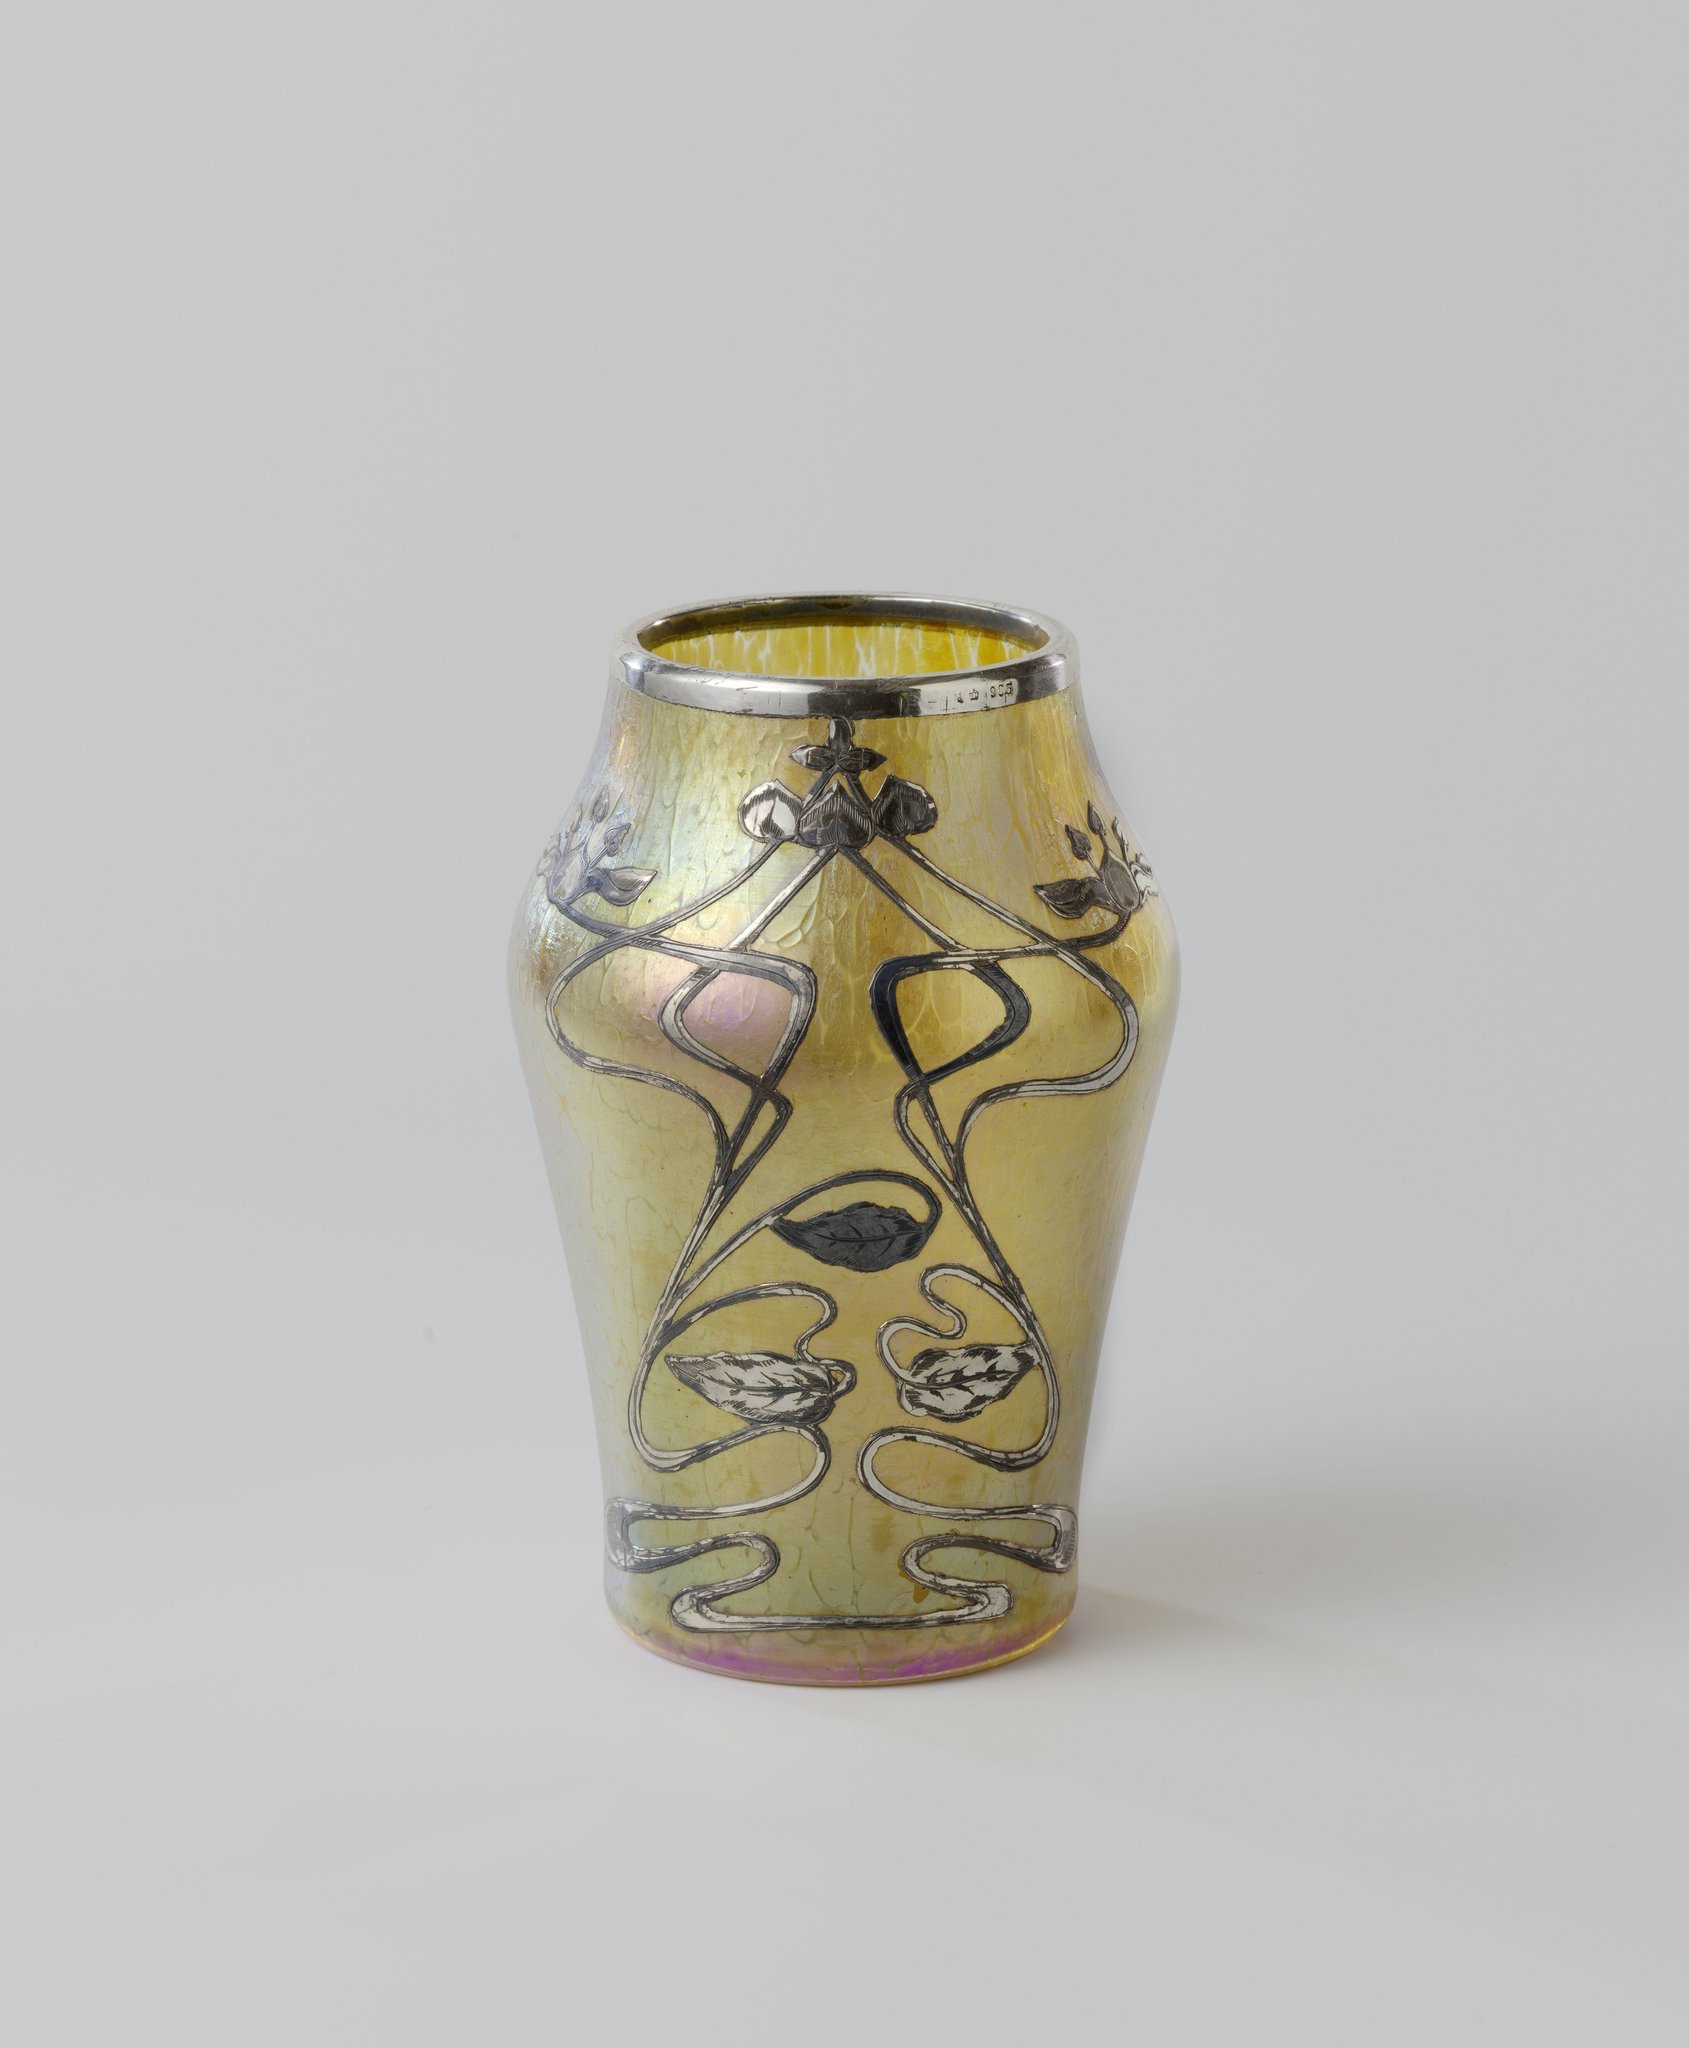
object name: vase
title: Vaas met zilverdecoratie van bladranken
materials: glass, silver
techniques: engraving, glassblowing, iridescence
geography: klostermühle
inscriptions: alloy mark: ‘935’, silver mark, silver mark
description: Platte bodem, dubbelconisch lichaam. Decoratie van ingewalste geelbruine glassplinters, goudkleurige irisering. Galvanoplastische zilverdecoratie van bladranken met gegraveerde details. Het zilver gemerkt in de bovenrand met kroon, maansikkel en gehaltemerk 935, Duitse zilvermerken in gebruik vanaf 1888.